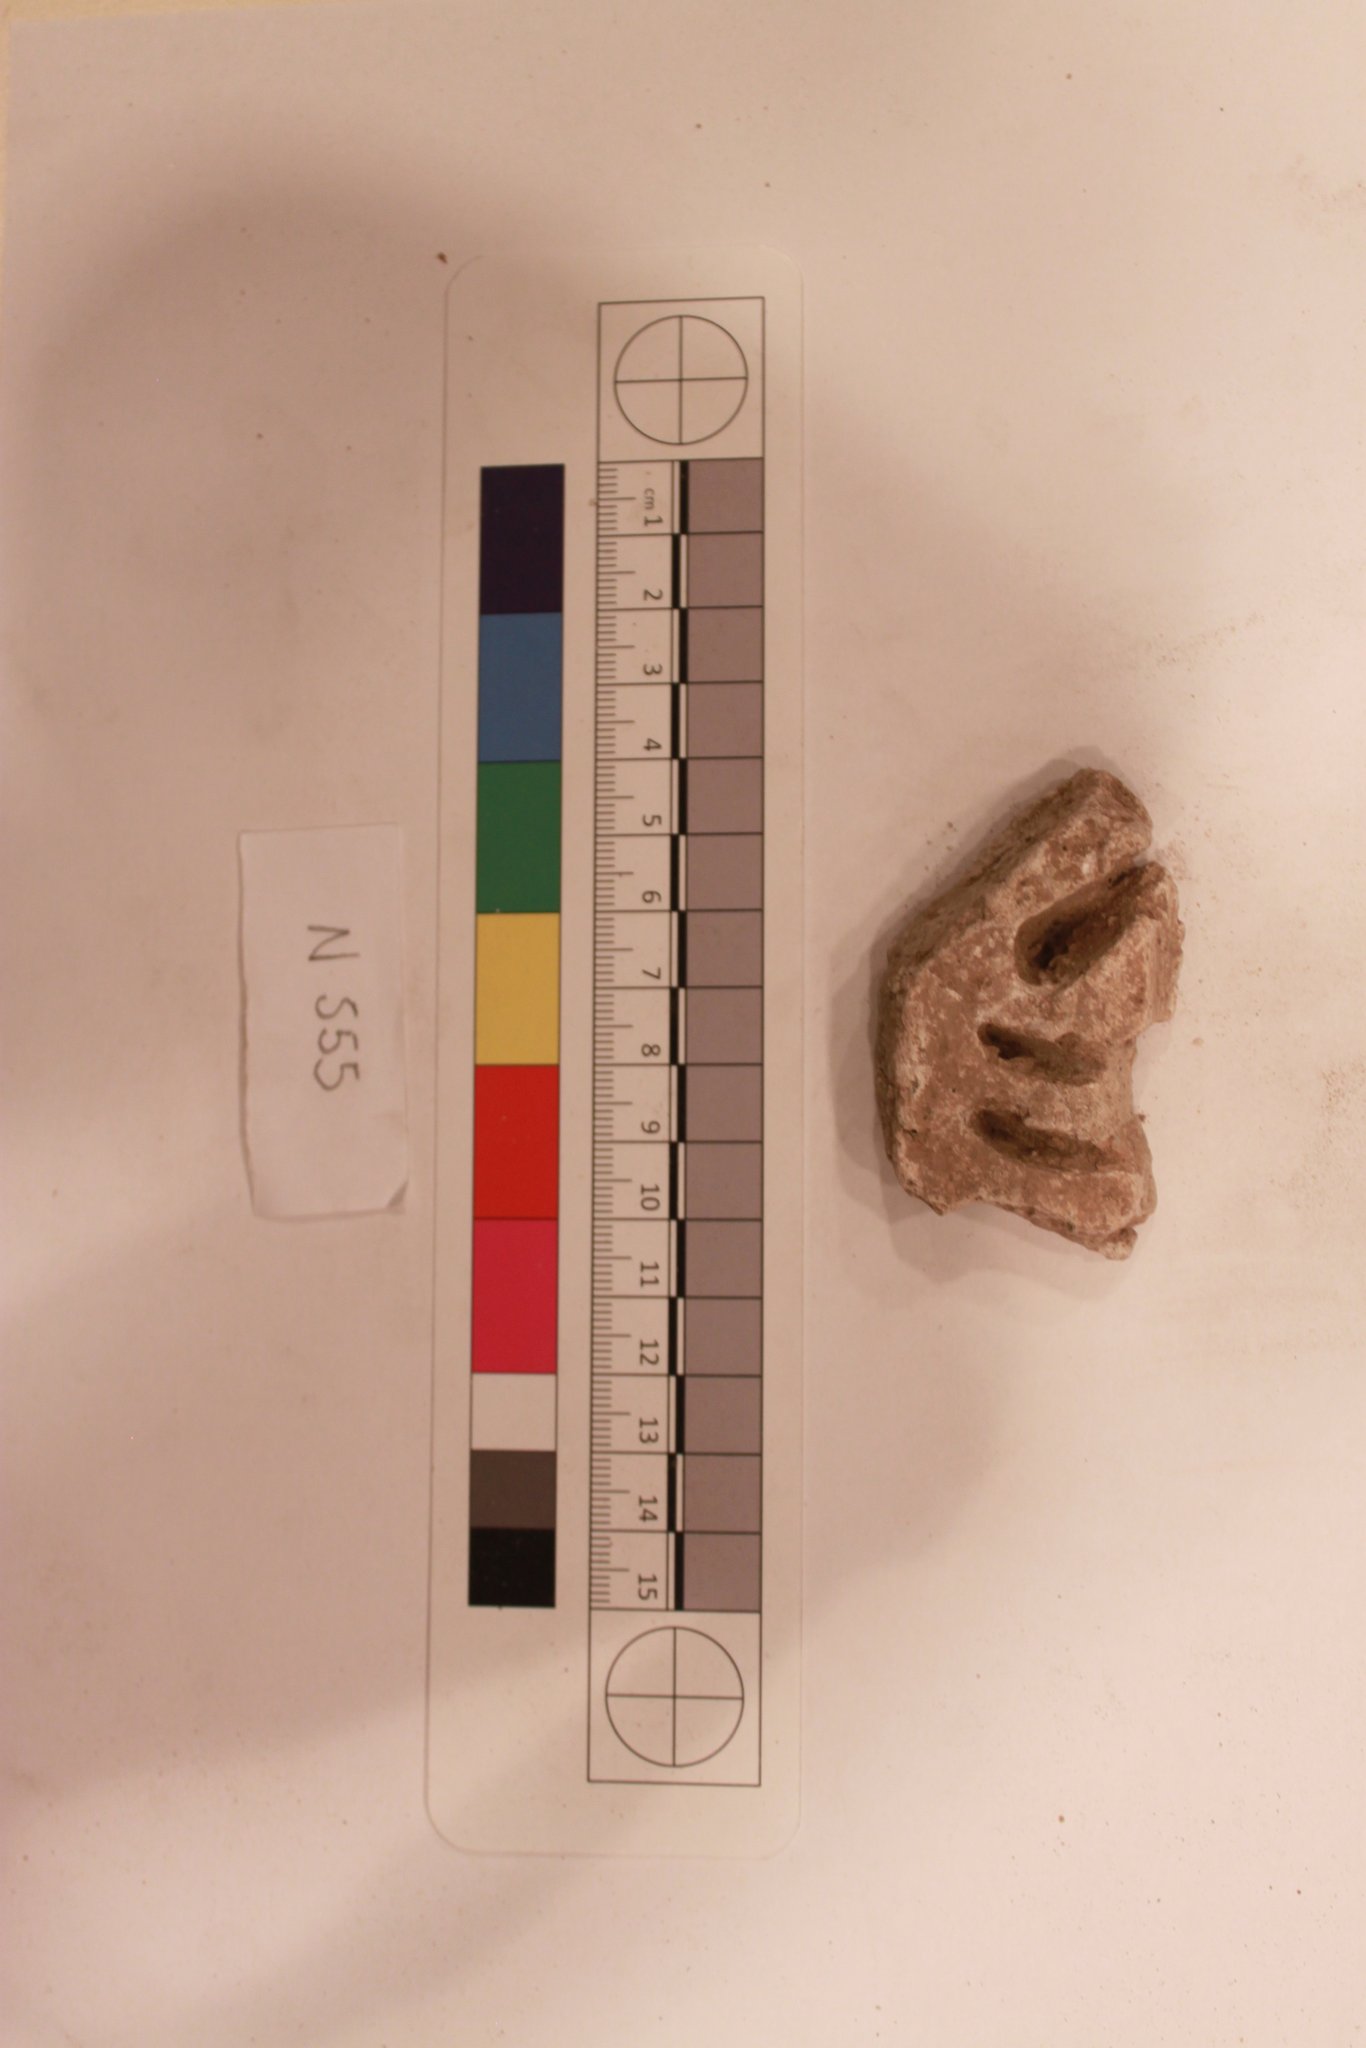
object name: fragment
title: Stucco Fragment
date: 701-1200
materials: plaster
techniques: carving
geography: iran